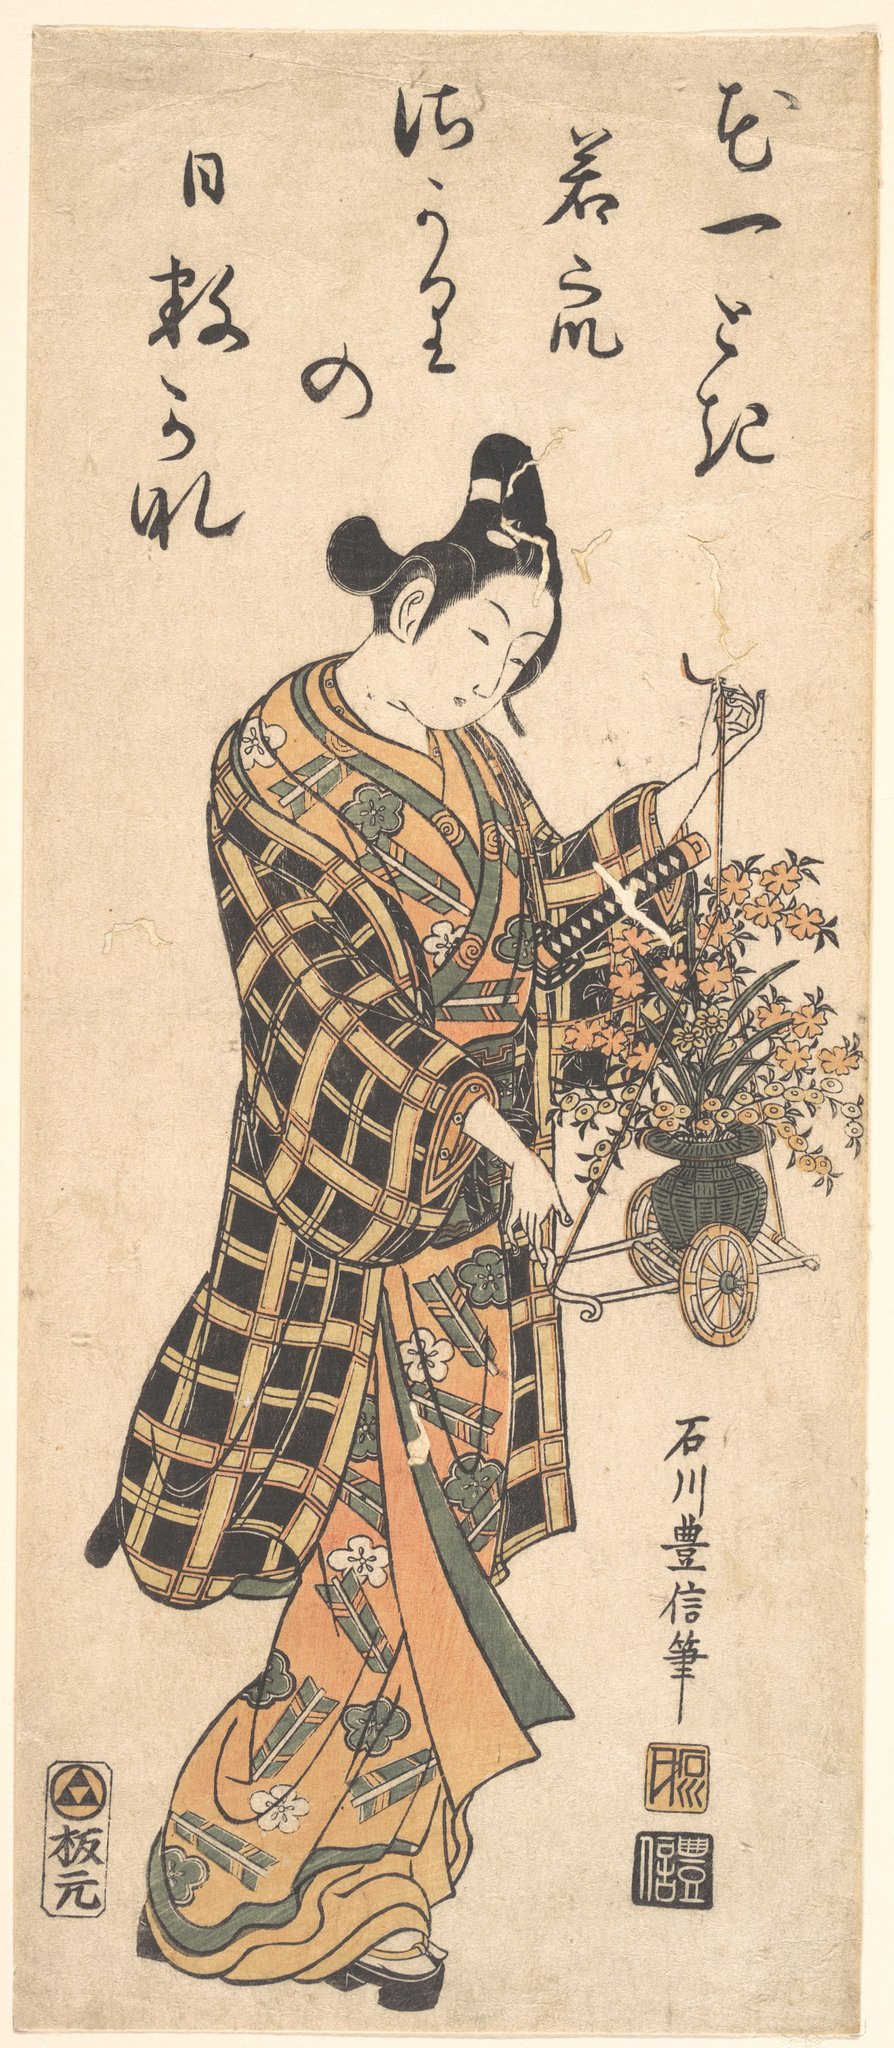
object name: woodblock print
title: Young Man (Wakashu) with a Miniature Flower Cart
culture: japanese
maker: ishikawa toyonobu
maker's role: artist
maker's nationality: japanese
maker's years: 1711-1785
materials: ink, paper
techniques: woodblock print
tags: men